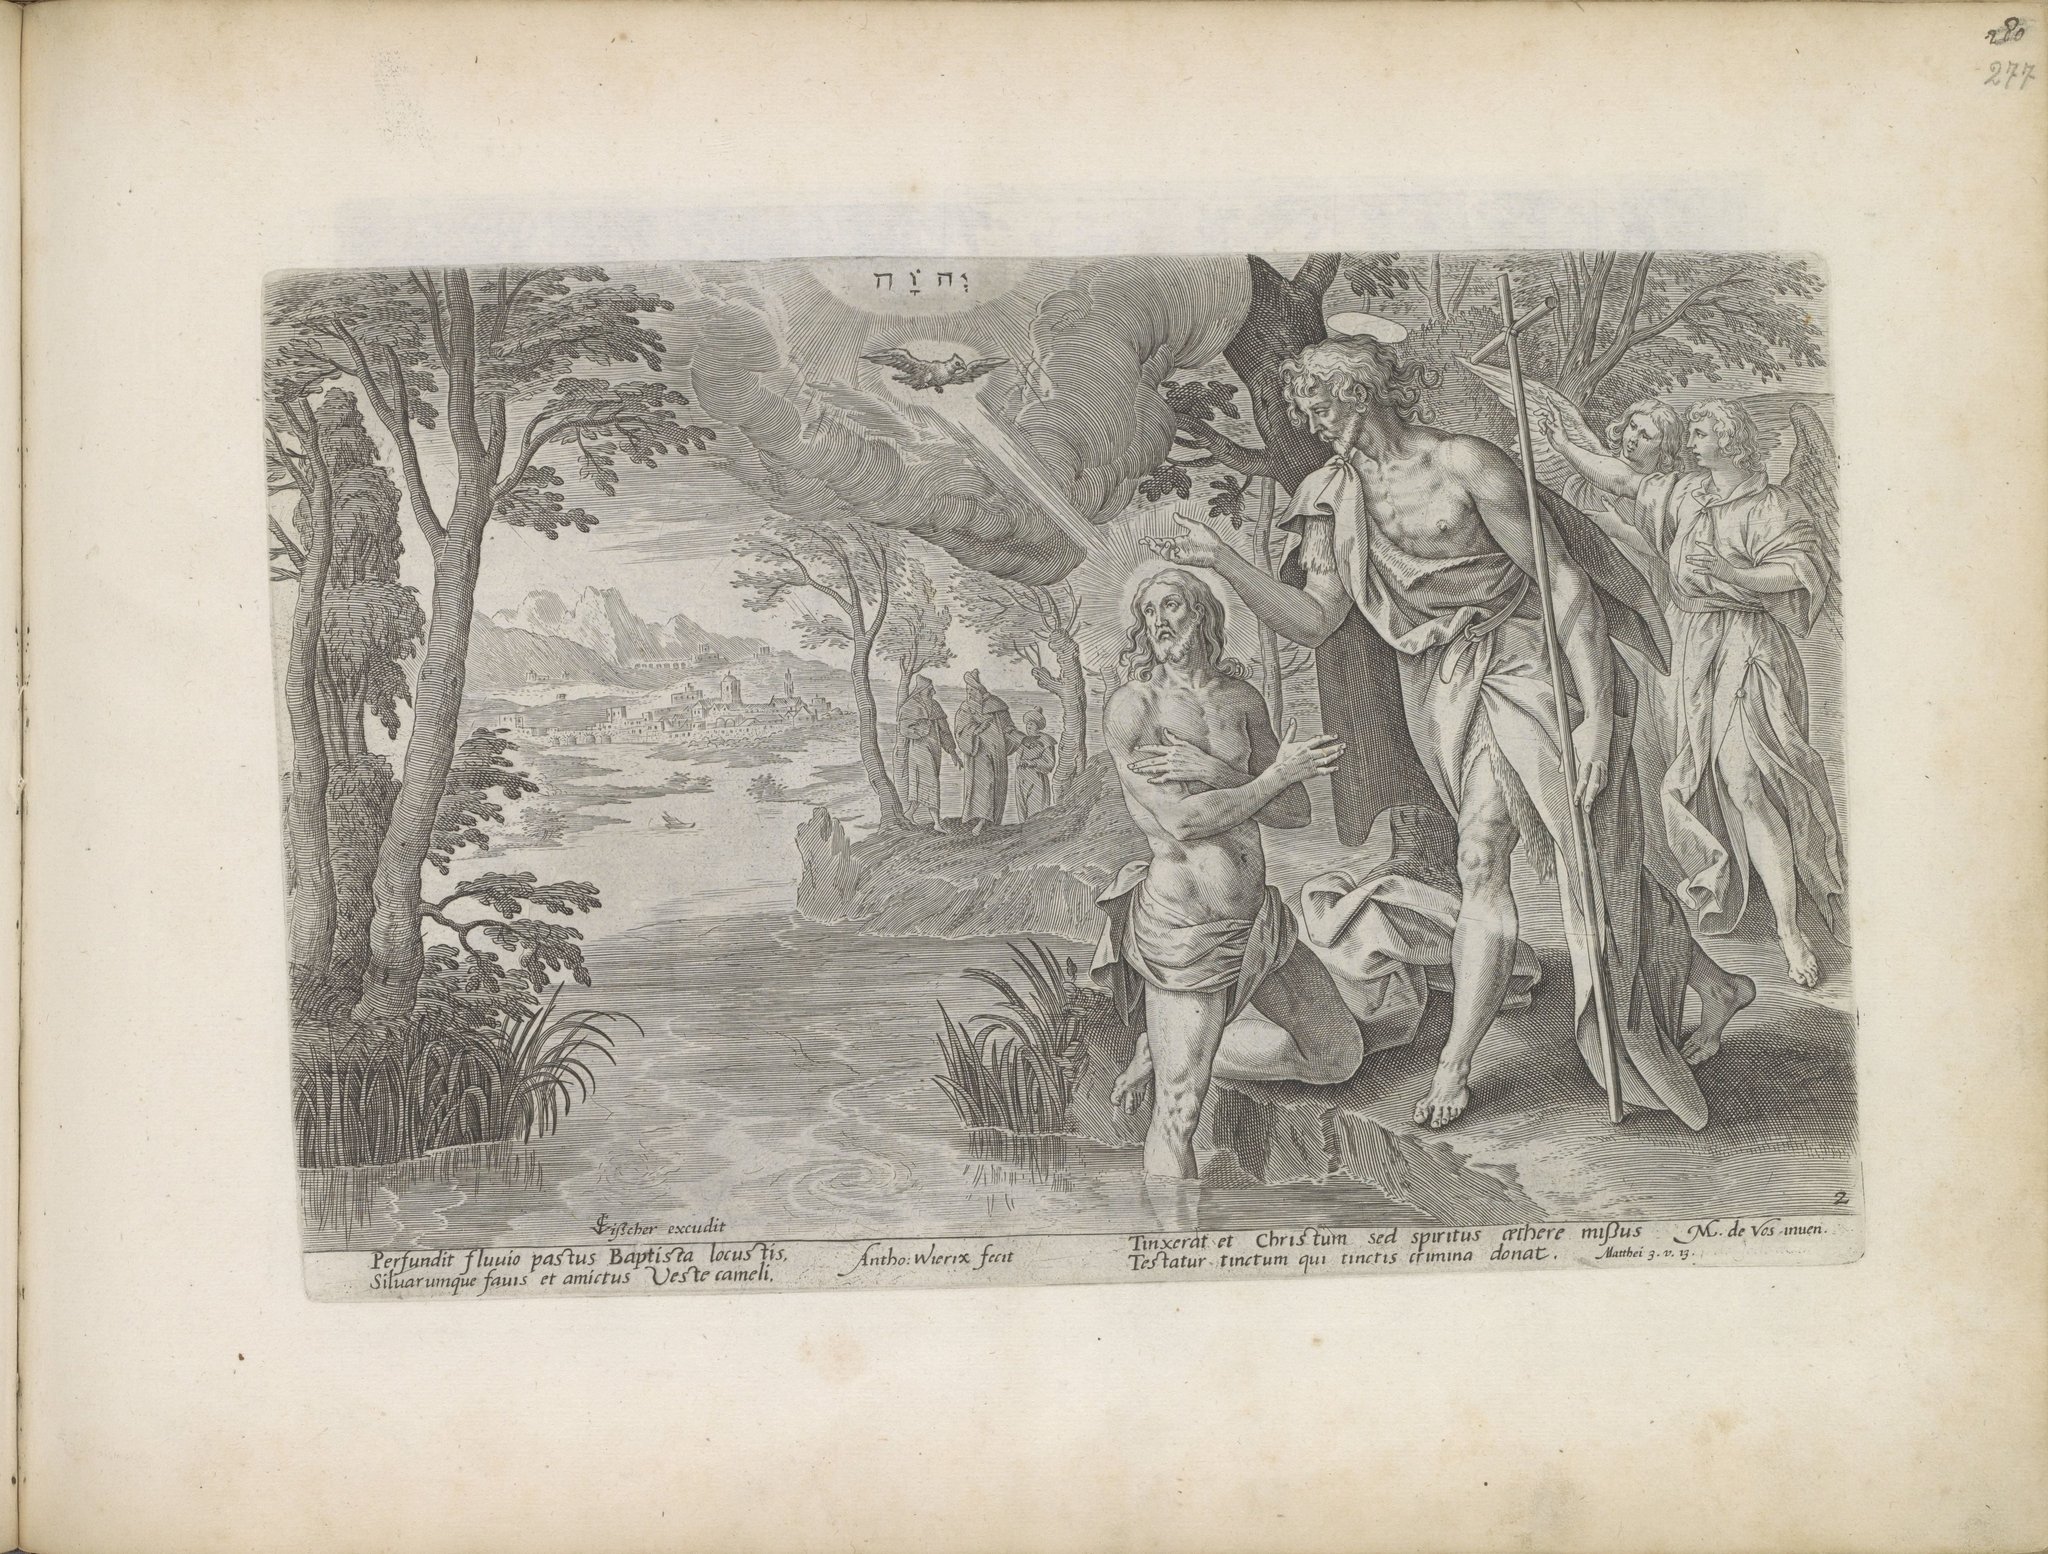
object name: print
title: Gebeurtenissen uit het leven van Johannes de Doper en Christus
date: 1584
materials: paper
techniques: engraving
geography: amsterdam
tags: baptism of christ in the river jordan: john the baptist pouring out water on christ's head: the holy ghost descends, tetragram (in roman or hebrew script) ~ symbol of god the father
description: Christus wordt gedoopt door Johannes de Doper en de Heilige Geest daalt als een duif op hem neer. Twee engelen kijken rechts toe. Onder de voorstelling een verwijzing in het Latijn naar de Bijbeltekst in Mat. 3:13. Deze prent maakt deel uit van een album.